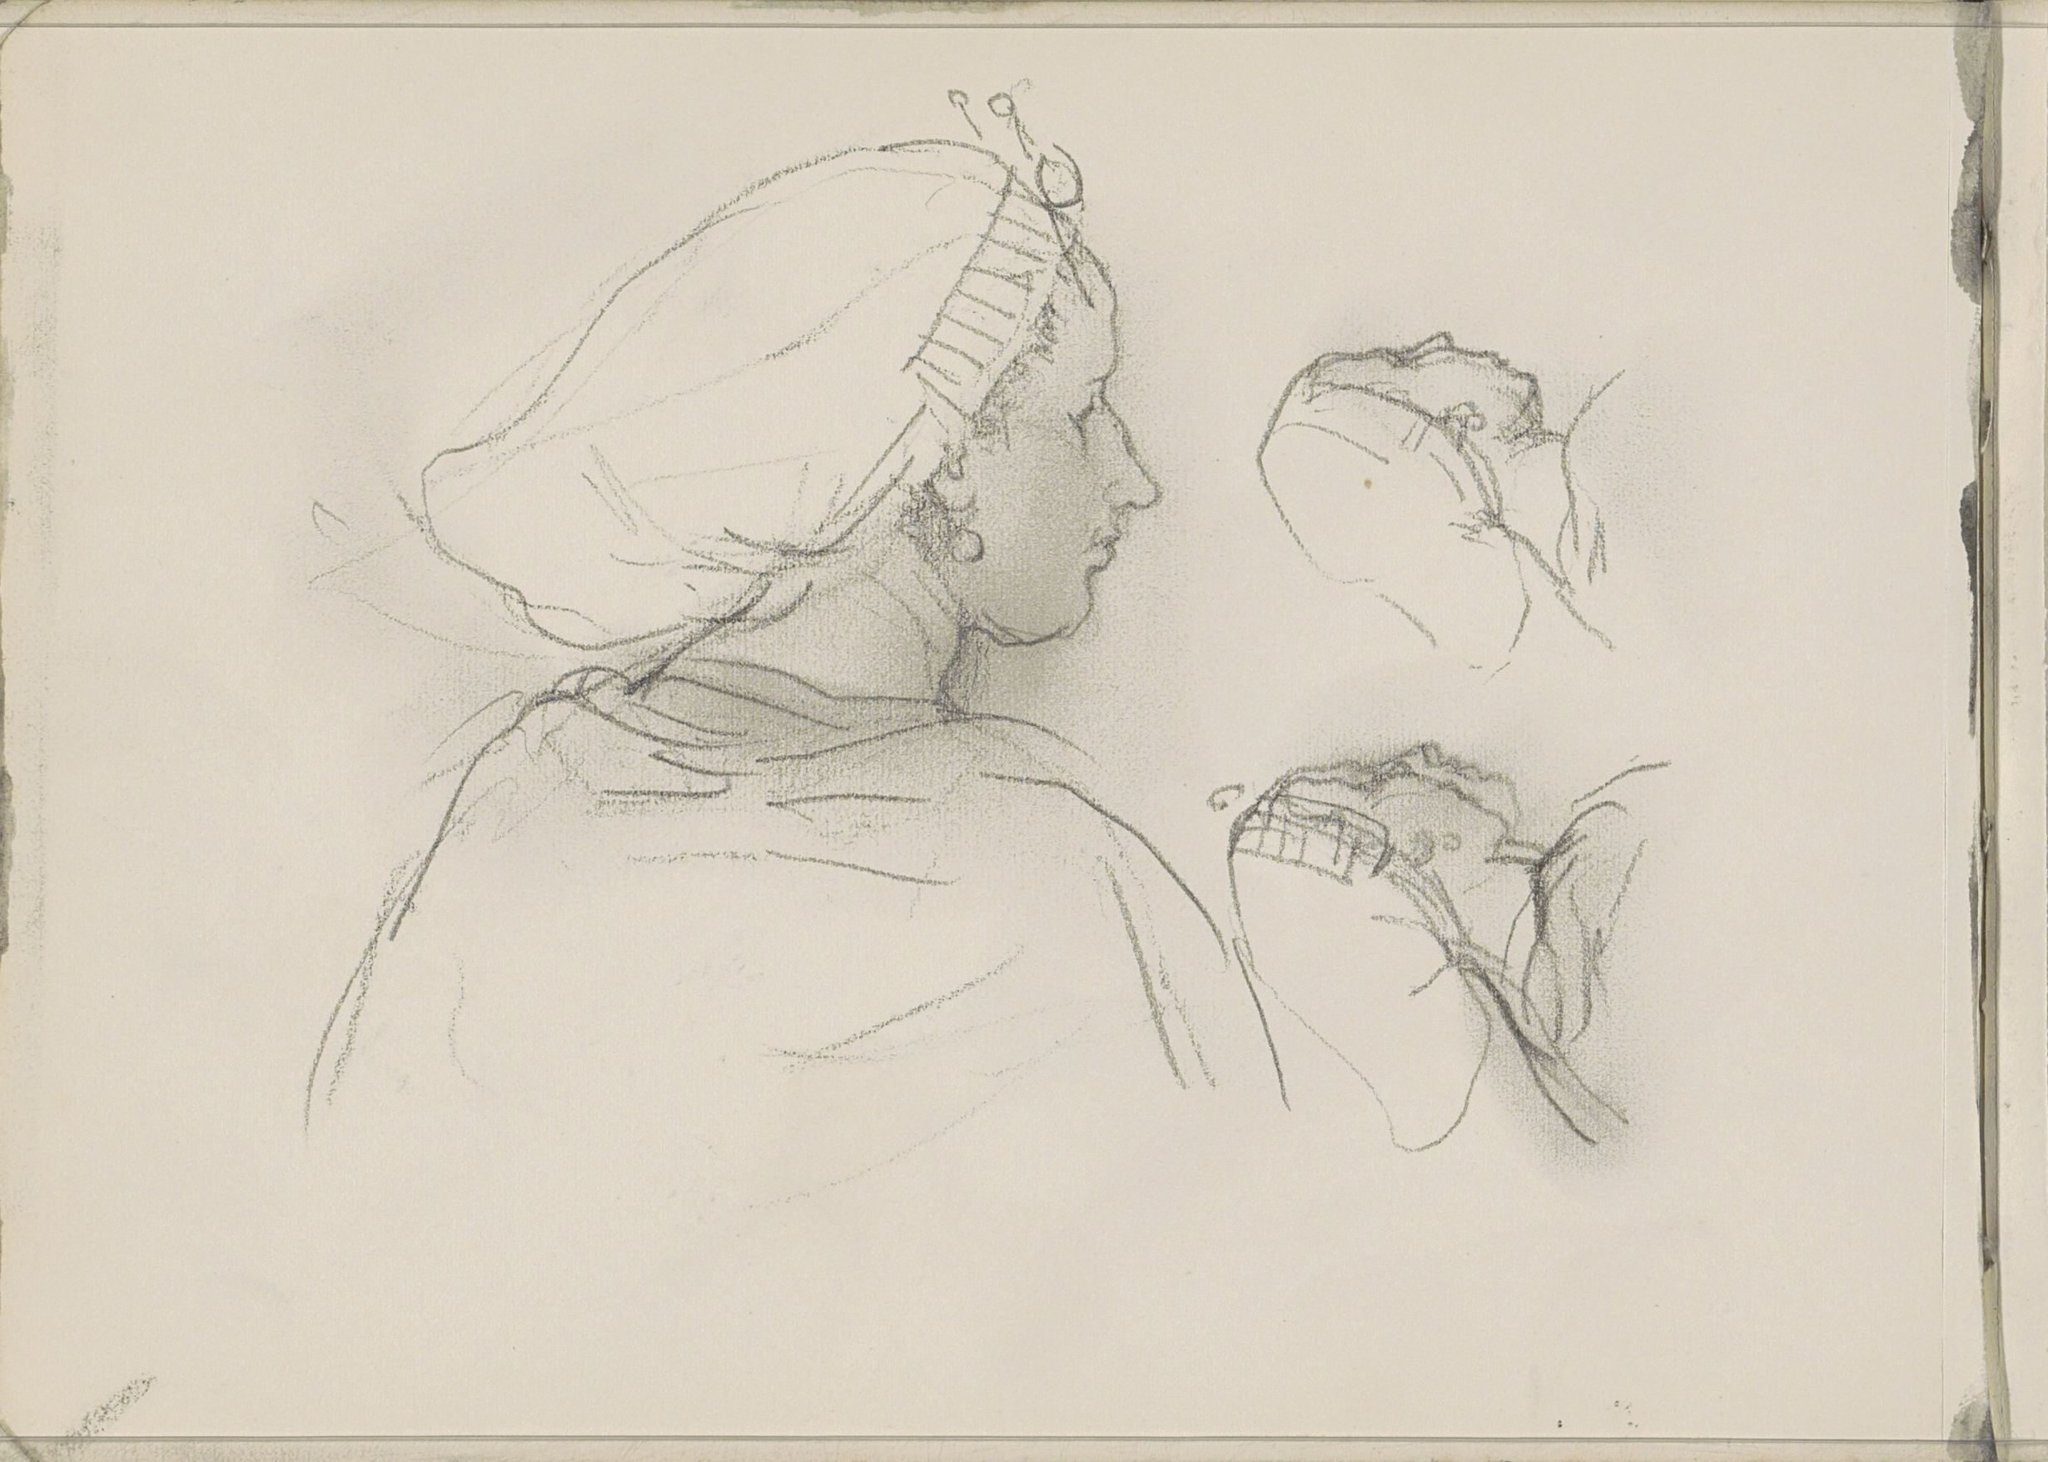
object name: sketchbook leaf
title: Studieblad met vrouwen in Scheveningse klederdracht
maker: johan antonie de jonge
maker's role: draughtsman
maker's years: 1864-1927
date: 1881-1927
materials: chalk, paper, pencil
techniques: stumping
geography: scheveningen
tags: folk costume, regional costume (+ women's clothes), adult woman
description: Studieblad met vrouwen in Scheveningse klederdracht. Blad 6 verso uit een schetsboek met 28 bladen.